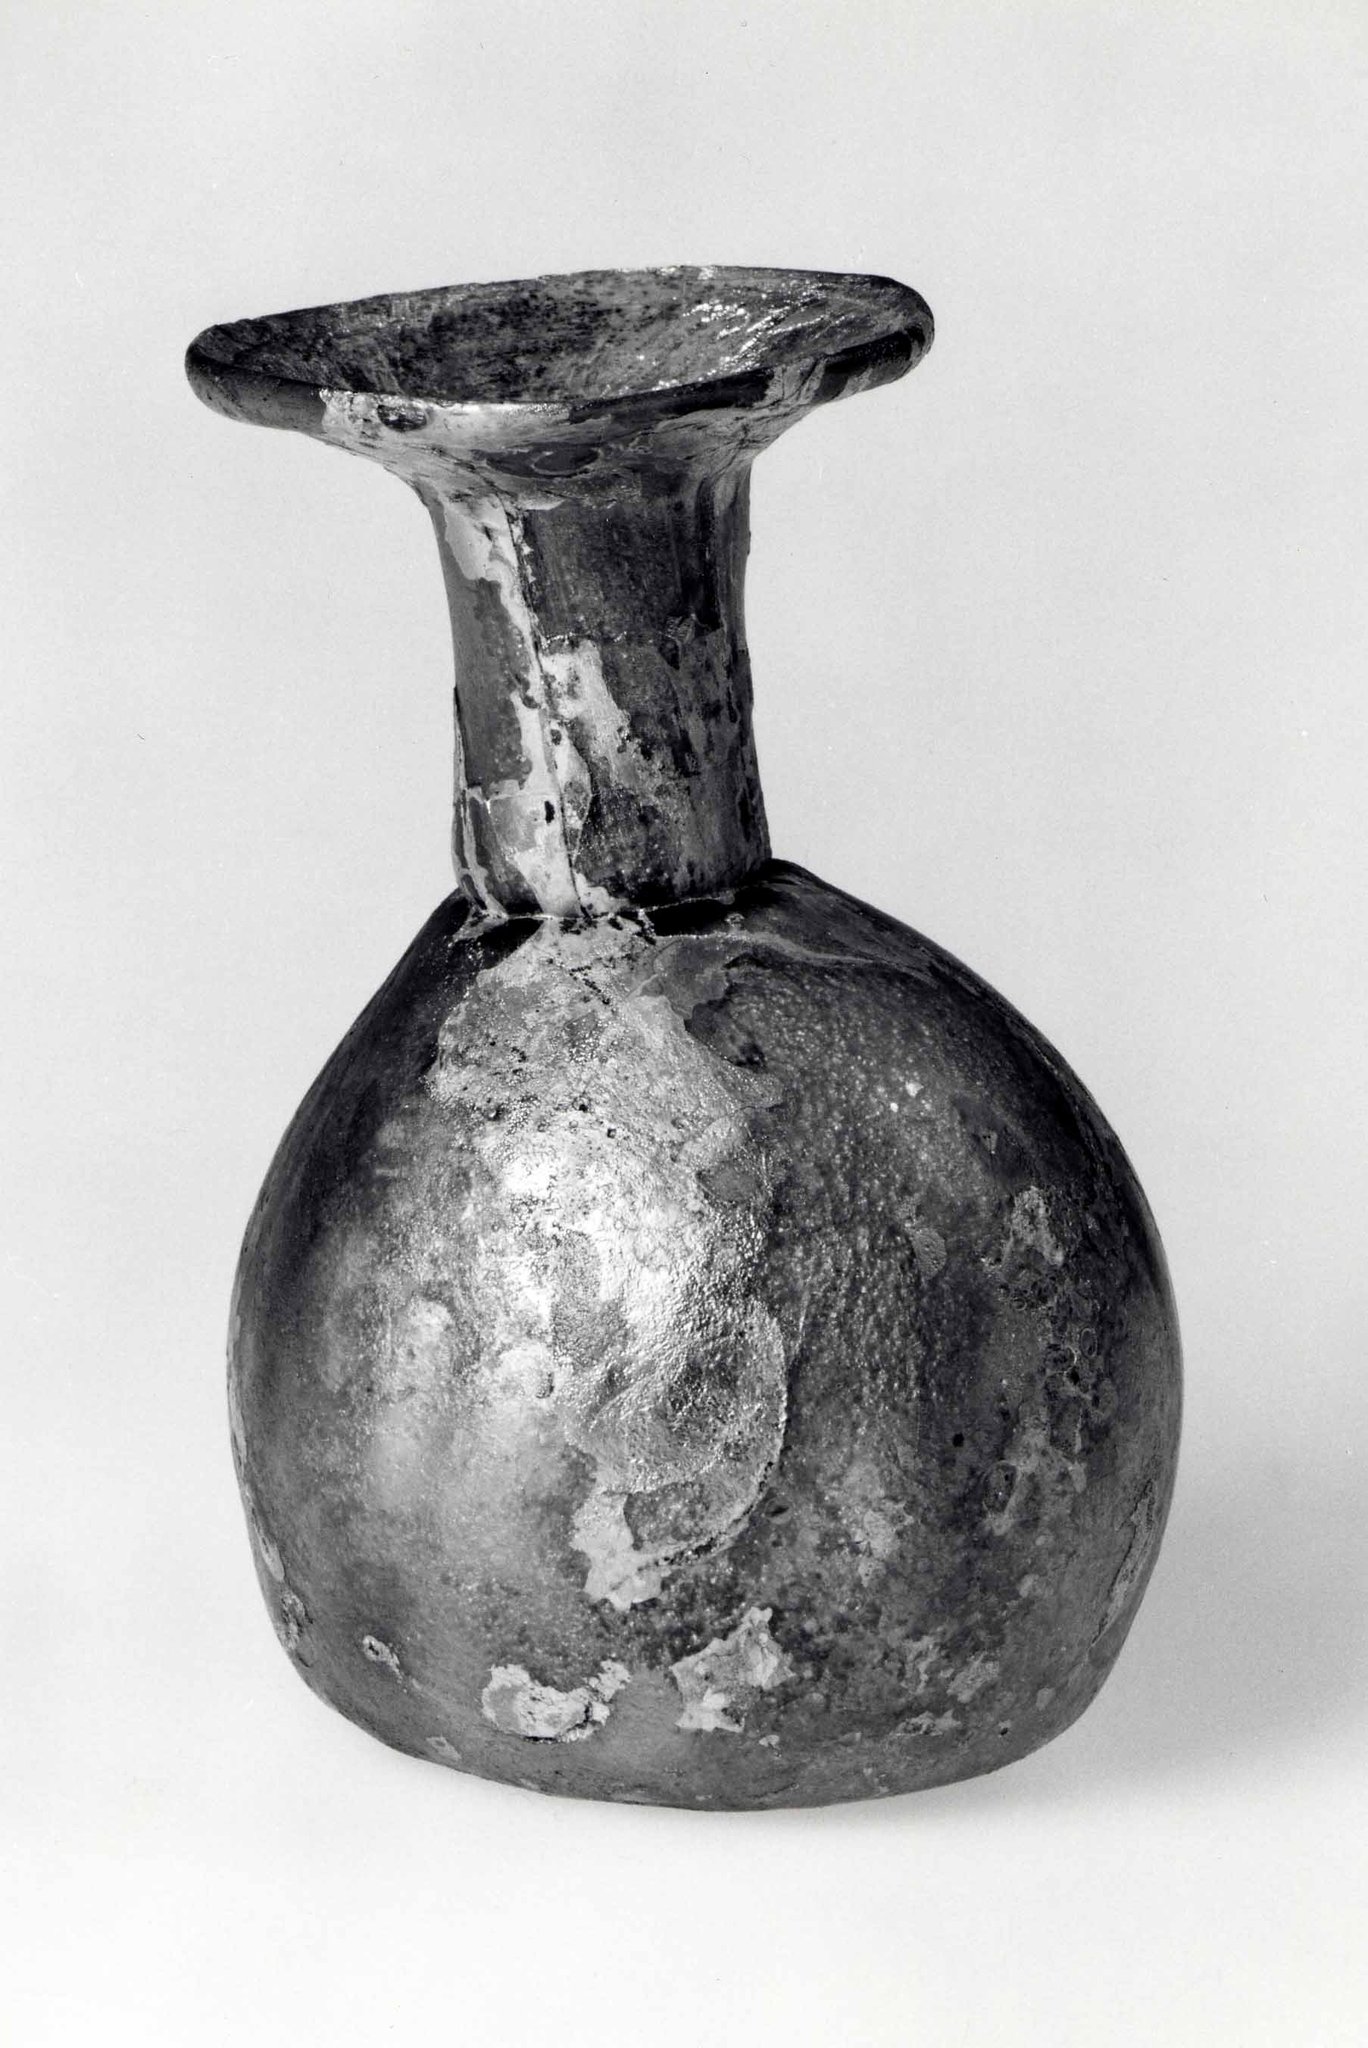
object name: dropper flask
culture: roman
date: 201-400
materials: glass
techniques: glassblowing, tooling